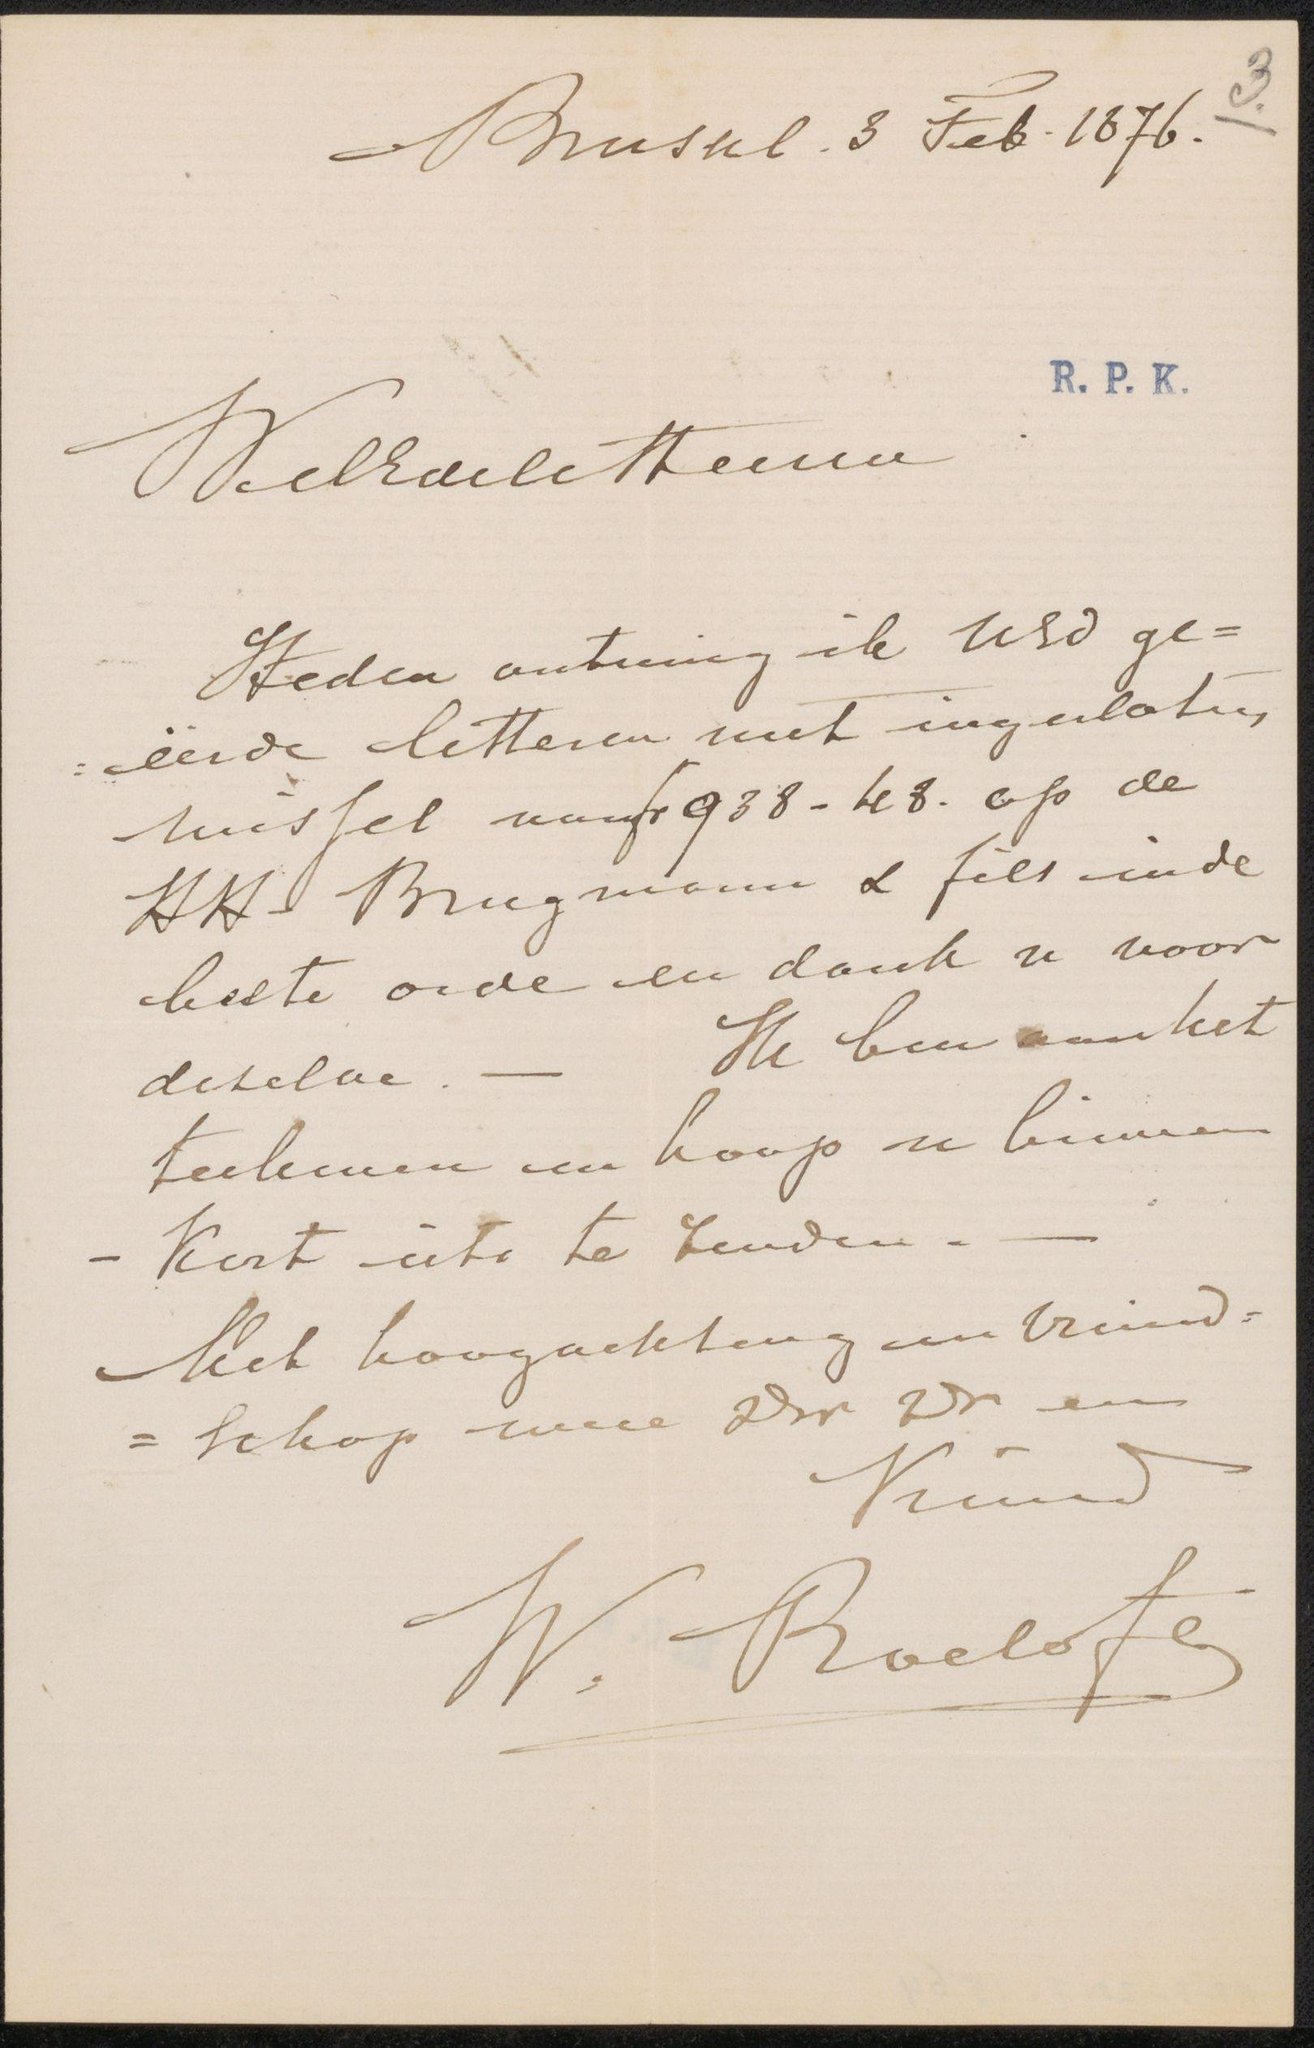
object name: letter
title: Brief aan Frans Buffa en Zonen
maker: willem roelofs (i)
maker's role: draughtsman, painter, print maker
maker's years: 1822-1897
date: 1876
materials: ink, paper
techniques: pen, writing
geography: brussels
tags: publisher, art trade, art shop, drawing, money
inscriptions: collector's mark: Lugt 2233